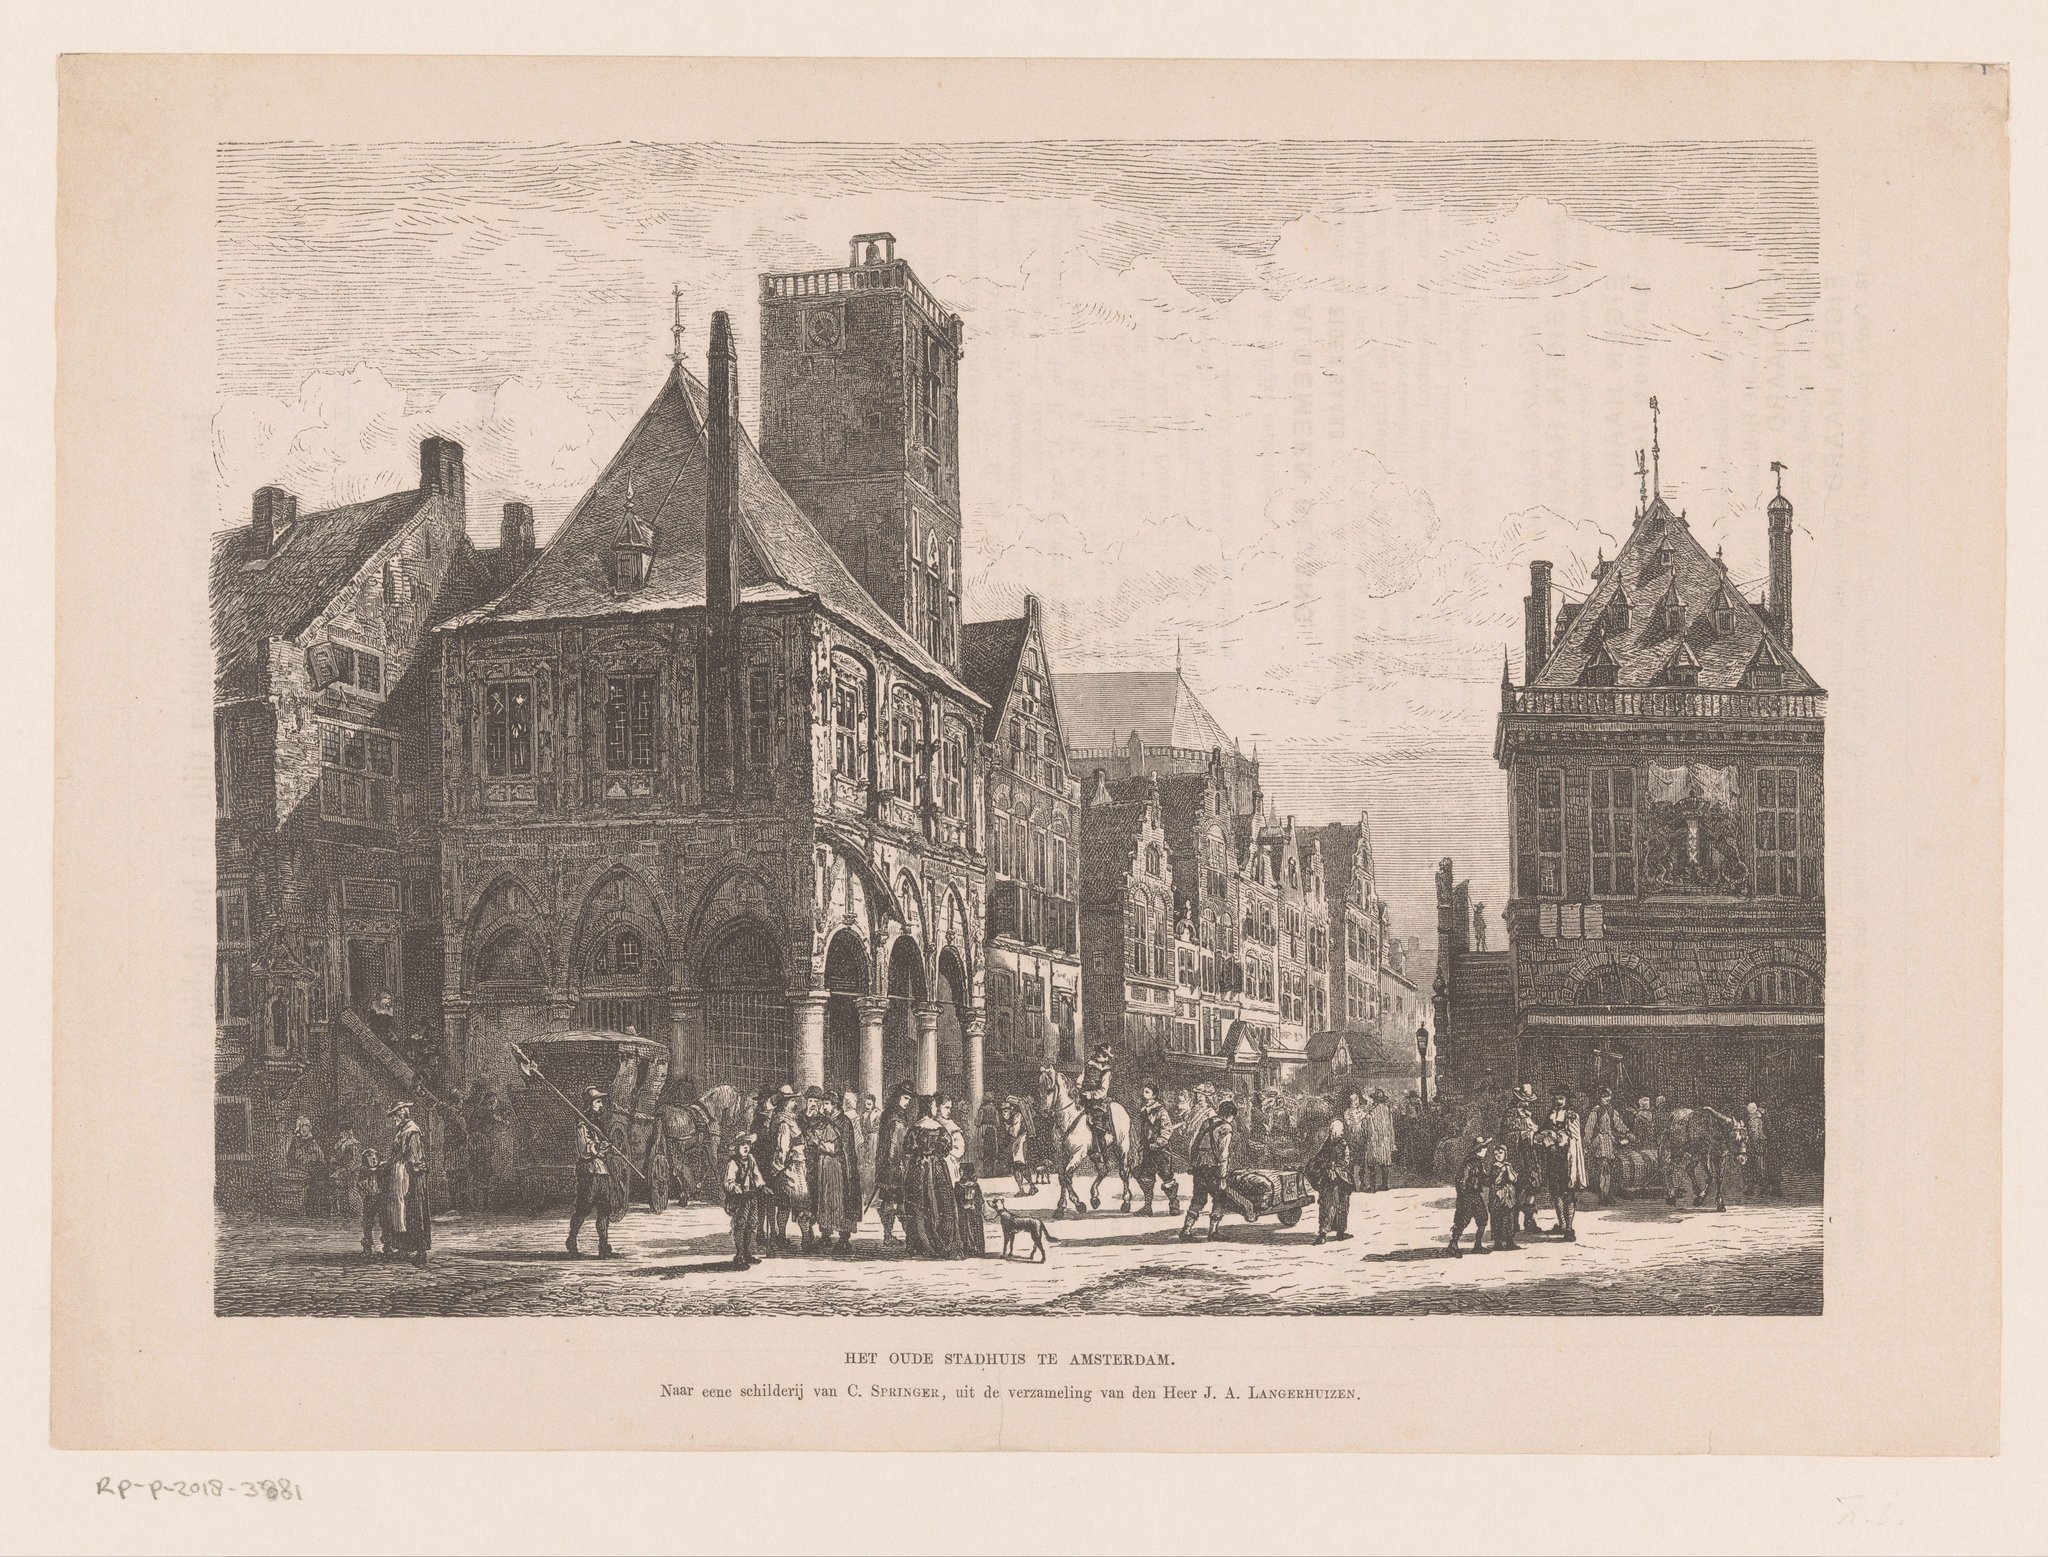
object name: book illustration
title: Het oude Stadhuis te Amsterdam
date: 1875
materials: paper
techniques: letterpress printing, engraving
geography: haarlem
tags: townhall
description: Naar een schilderij van Cornelis Springer uit de verzameling van de heer J.A. Langerhuizen. Prent uit: Eigen Haard: geïllustreerd volkstijdschrift. Haarlem: Kruseman & Tjeenk Willink, 1875.